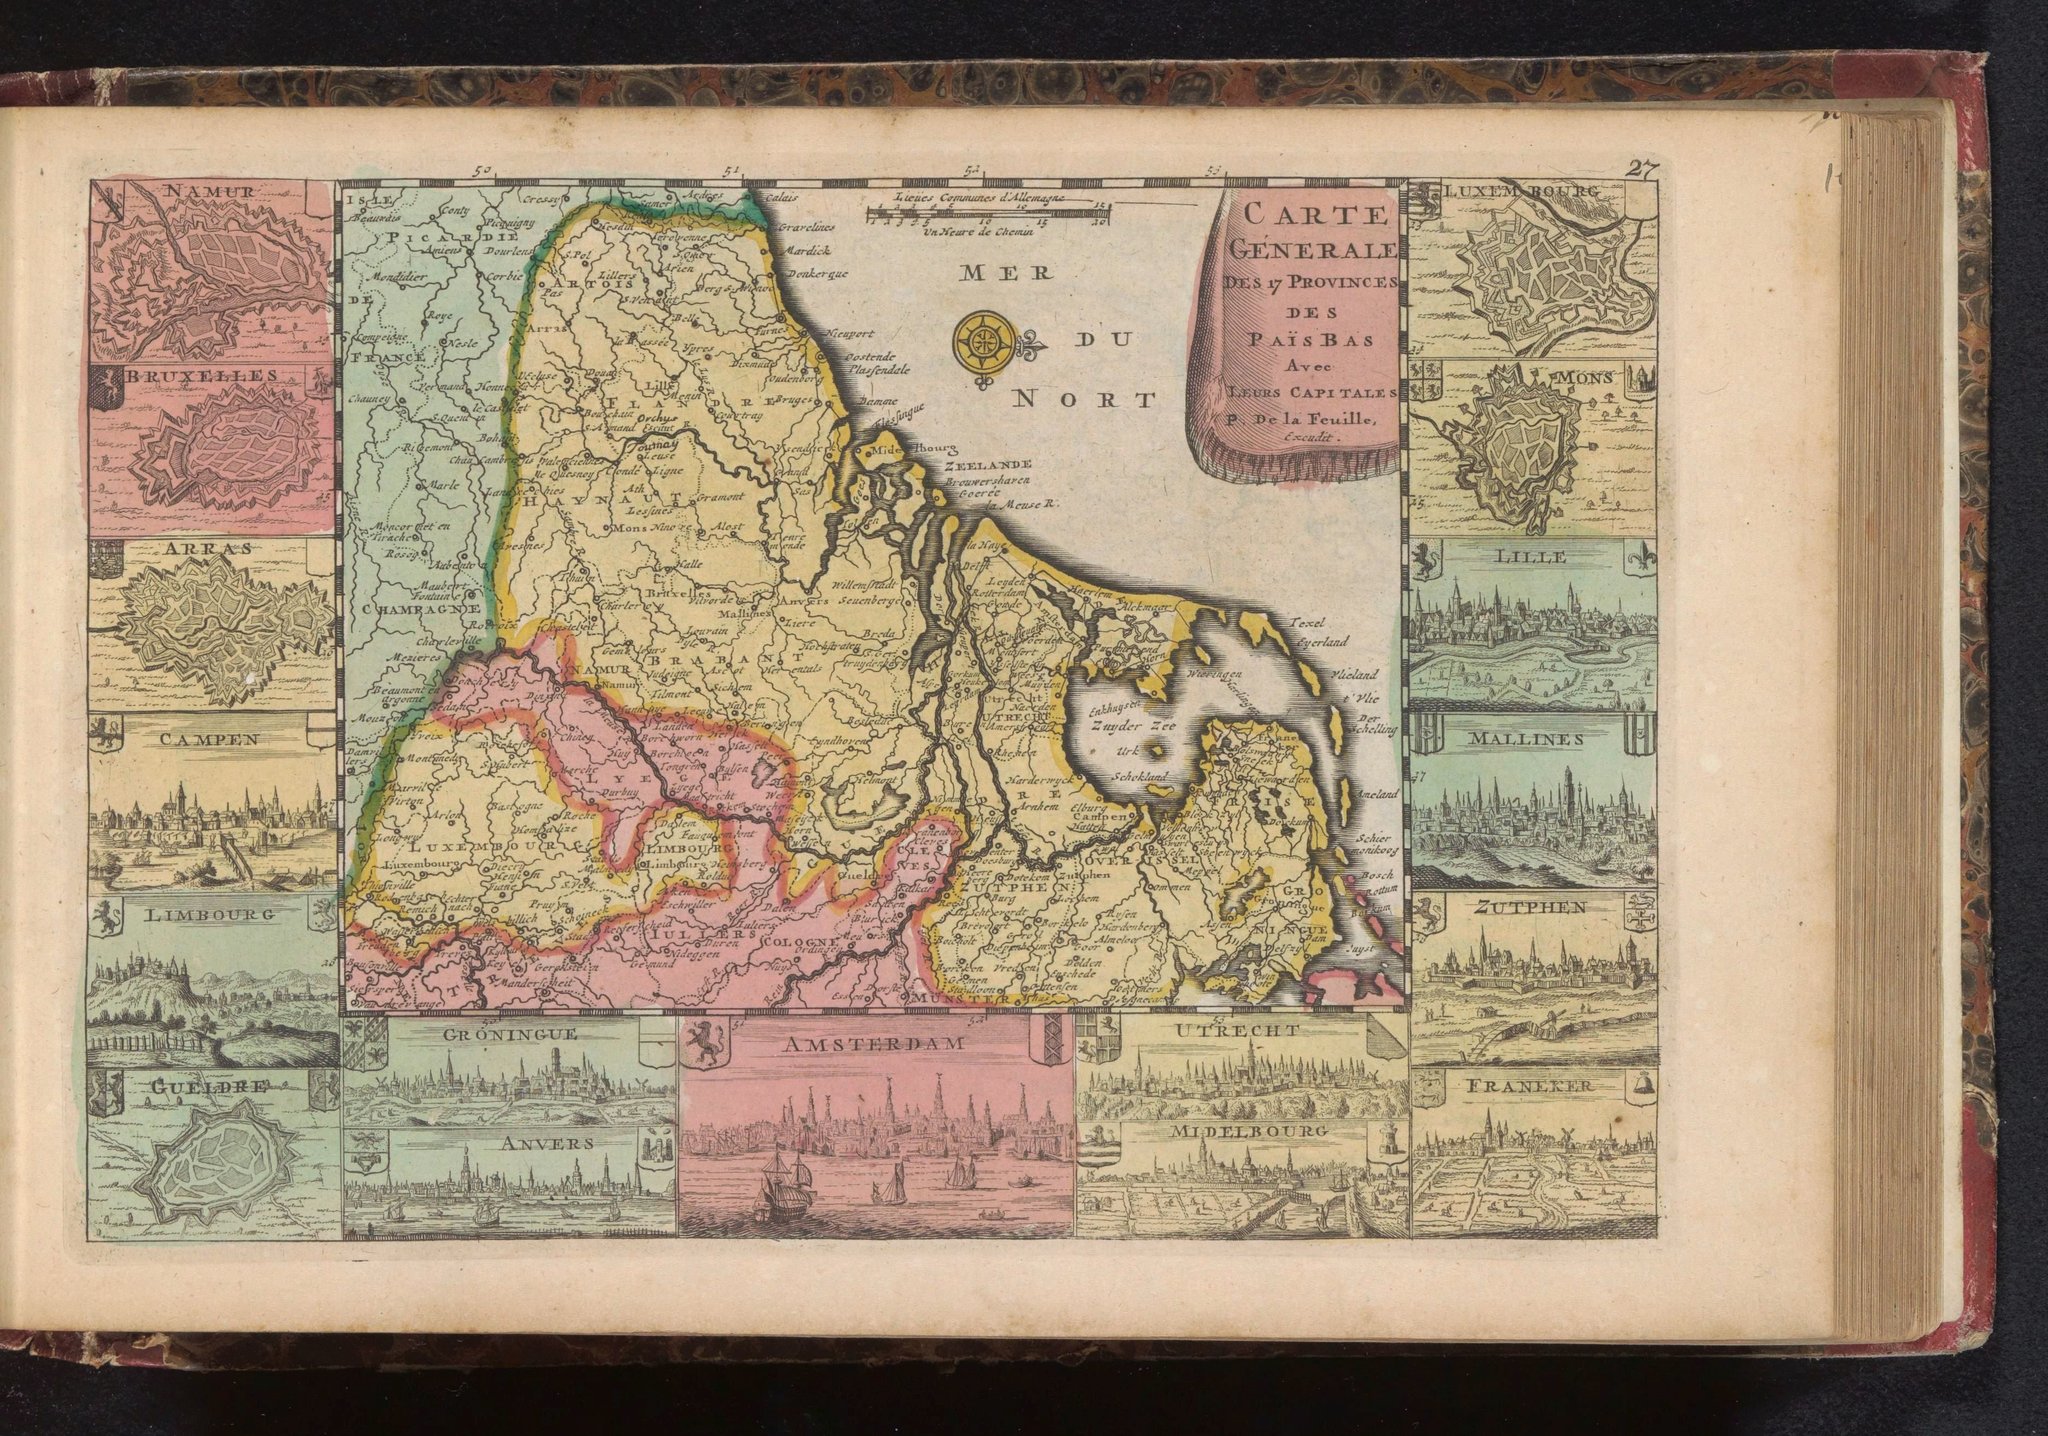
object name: map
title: Kaart van de Nederlanden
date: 1700-1702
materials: paper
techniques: engraving, etching, hand coloring, lacquer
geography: northern netherlands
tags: maps of separate countries or regions, low countries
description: Kaart van de zeventien provincies van de Noordelijke en Zuidelijke Nederlanden. Omringd door zeventien plattegronden en gezichten op steden. Onderdeel van een atlas met 223 kaarten van landen en steden en oorlogstaferelen in Europa in de periode ca. 1690-1735.